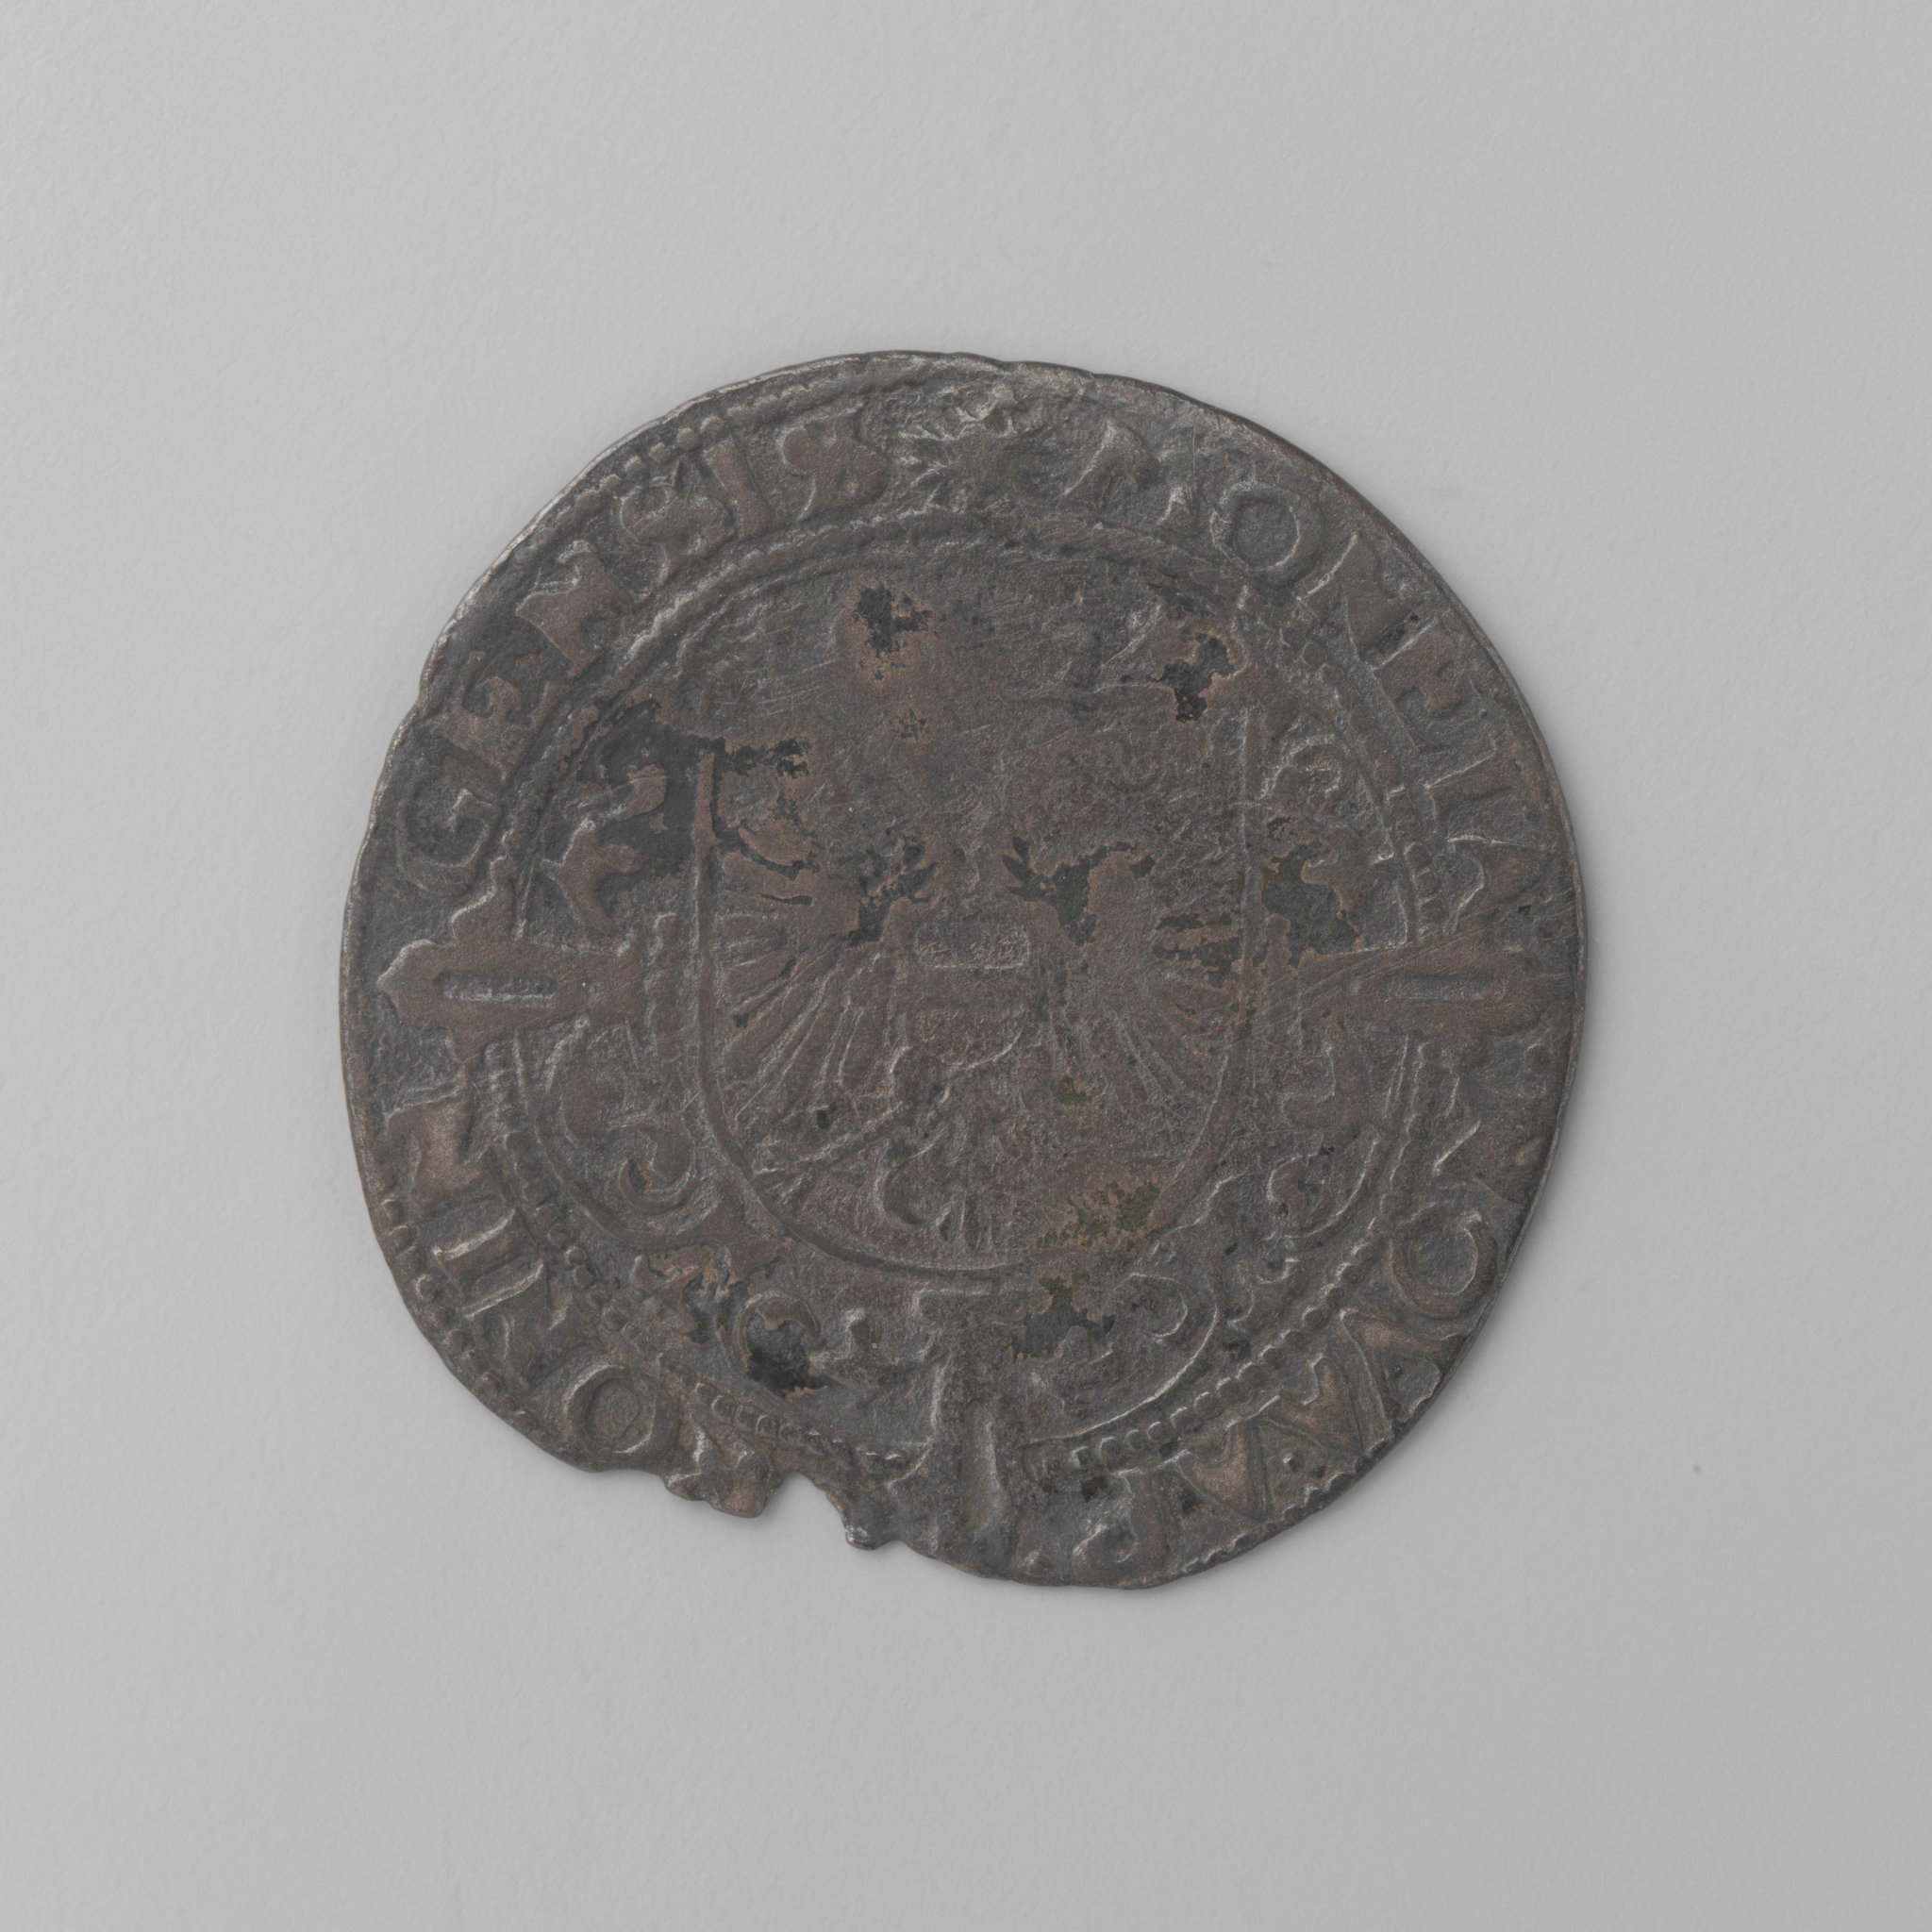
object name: coin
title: Groningen, flabbe, 1599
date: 1599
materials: silver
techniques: striking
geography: groningen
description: Zilveren munt. Voorzijde: op lang gebloemd kruis in vierpas wapenschild, waarboven twee sterretjes. Kort gebloemd kruis, in het hart wapenschild. Jaartal in omschrift.